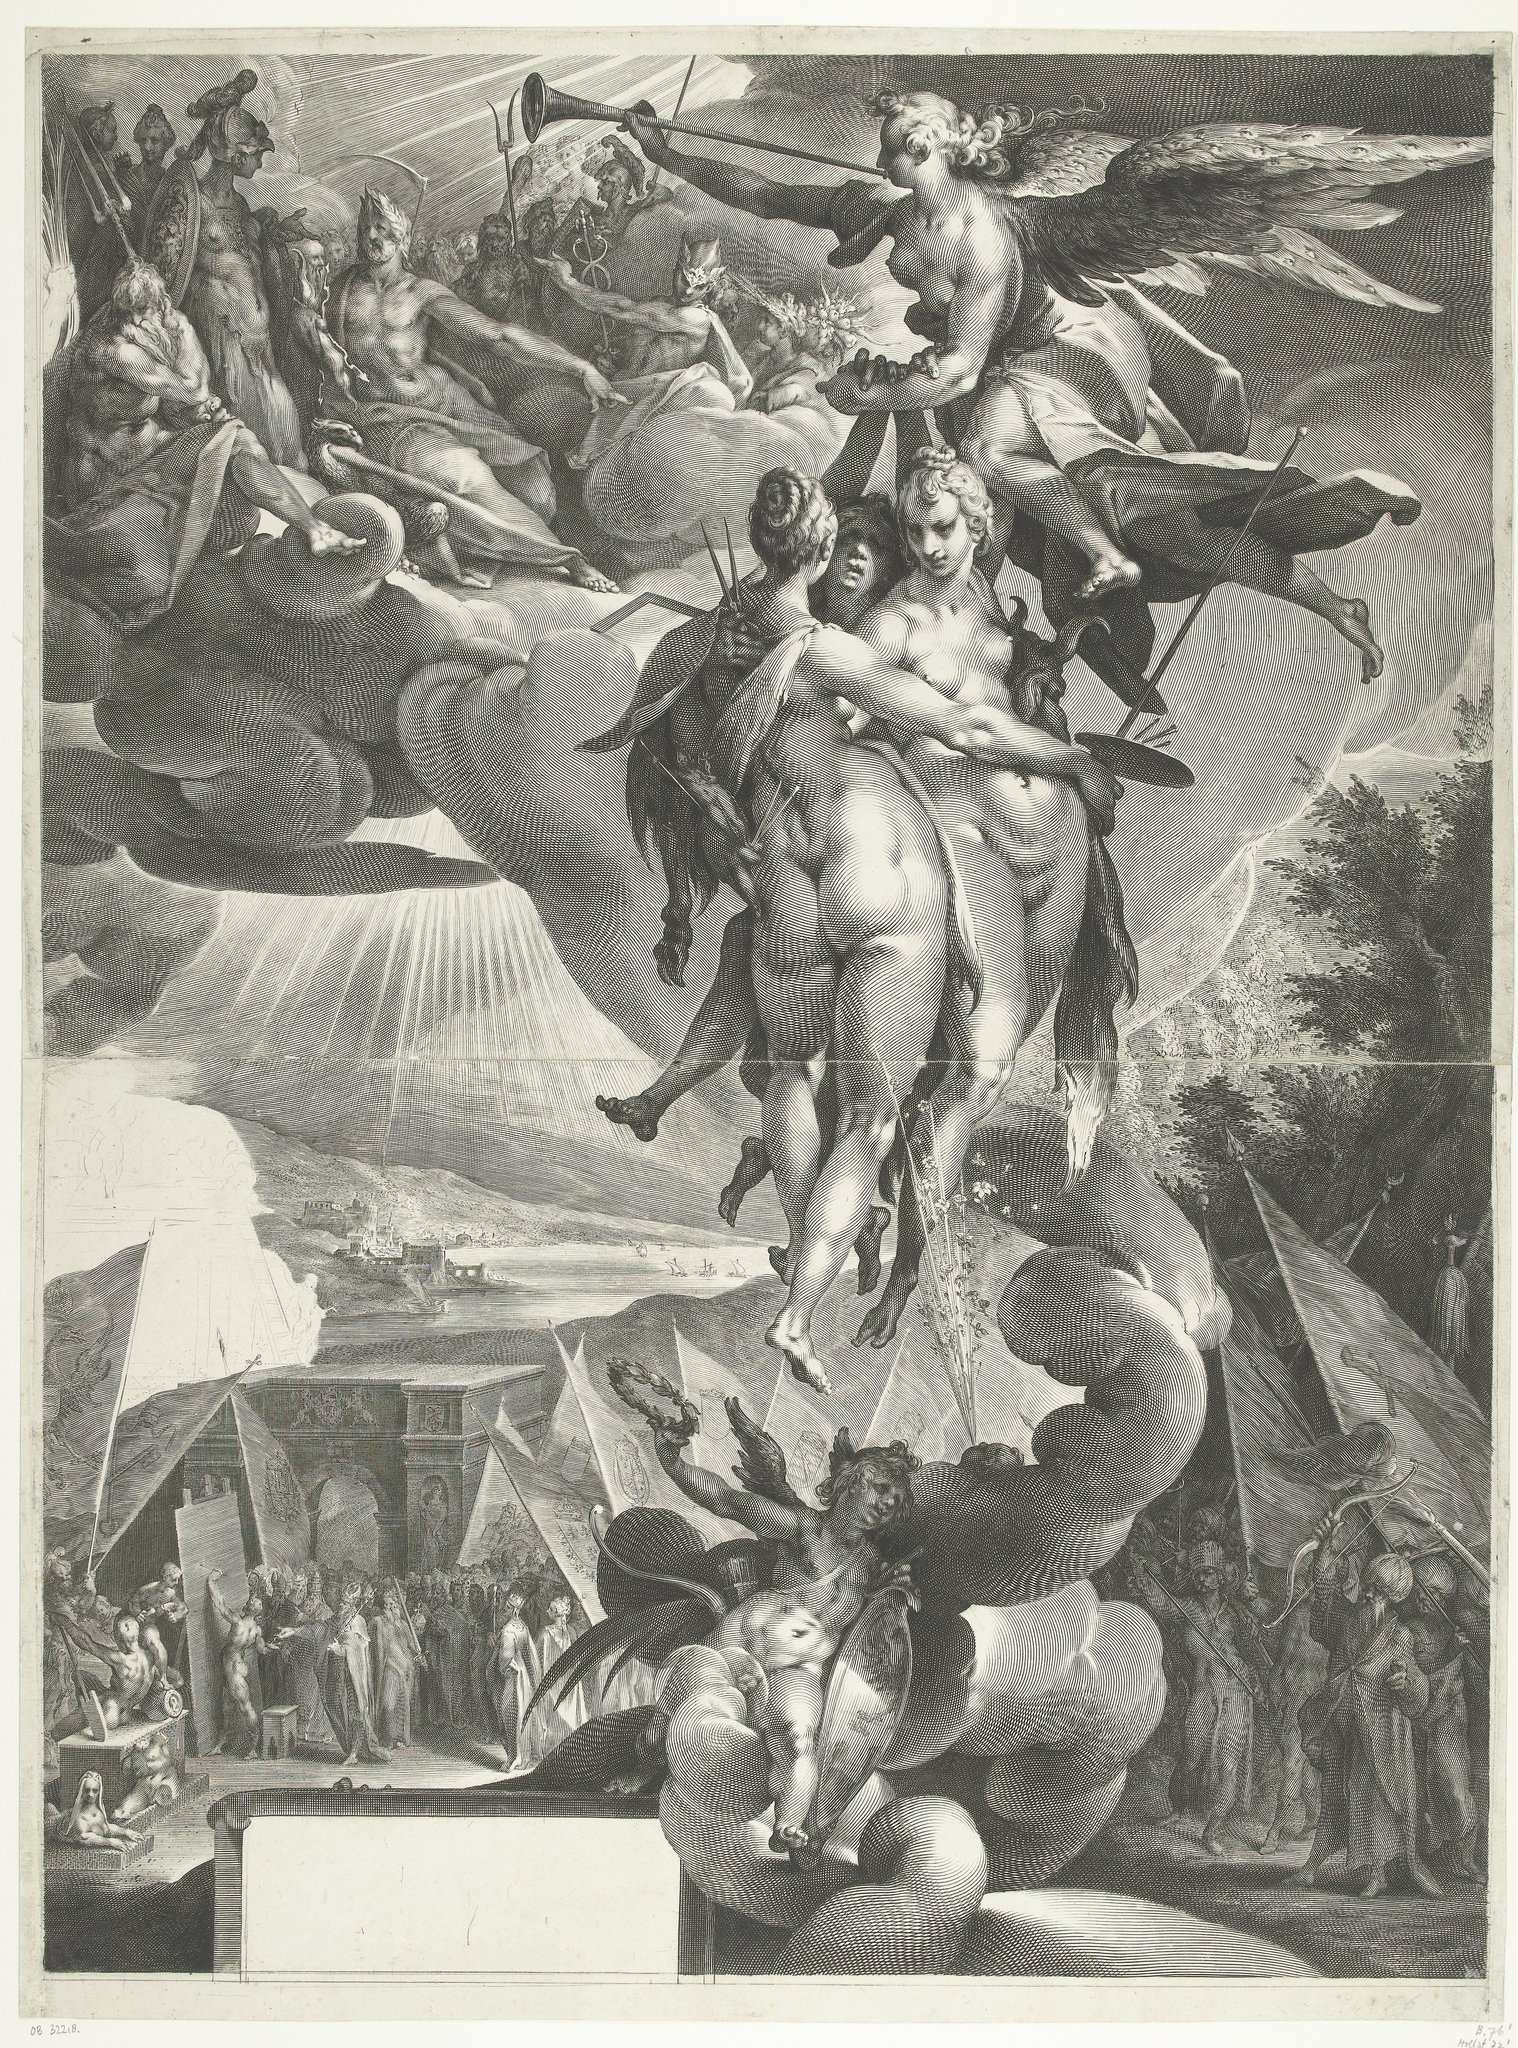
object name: print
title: Apotheose van de kunsten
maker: jan harmensz. muller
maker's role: draughtsman, print maker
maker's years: 1571-1628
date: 1597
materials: paper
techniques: engraving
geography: amsterdam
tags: 'pictura', symbolic representations, allegories and emblems ~ painting; 'pittura' (ripa), 'sculptura', symbolic representations, allegories and emblems ~ sculpture; 'scoltura' (ripa), 'architectura', symbolic representations, allegories and emblems ~ architecture; 'architettura' (ripa), olympus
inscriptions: collector's mark: Lugt 240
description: De apotheose van Architectuur, Sculptuur en Schilderkunst. Zij worden door Faam omhoog gevoerd naar de goden van de Olympus, die bijeen zitten op de wolken. Linksonder geven koningen, keizers en de paus opdrachten aan kunstenaars. Rechtsonder een groep Turkse strijders.